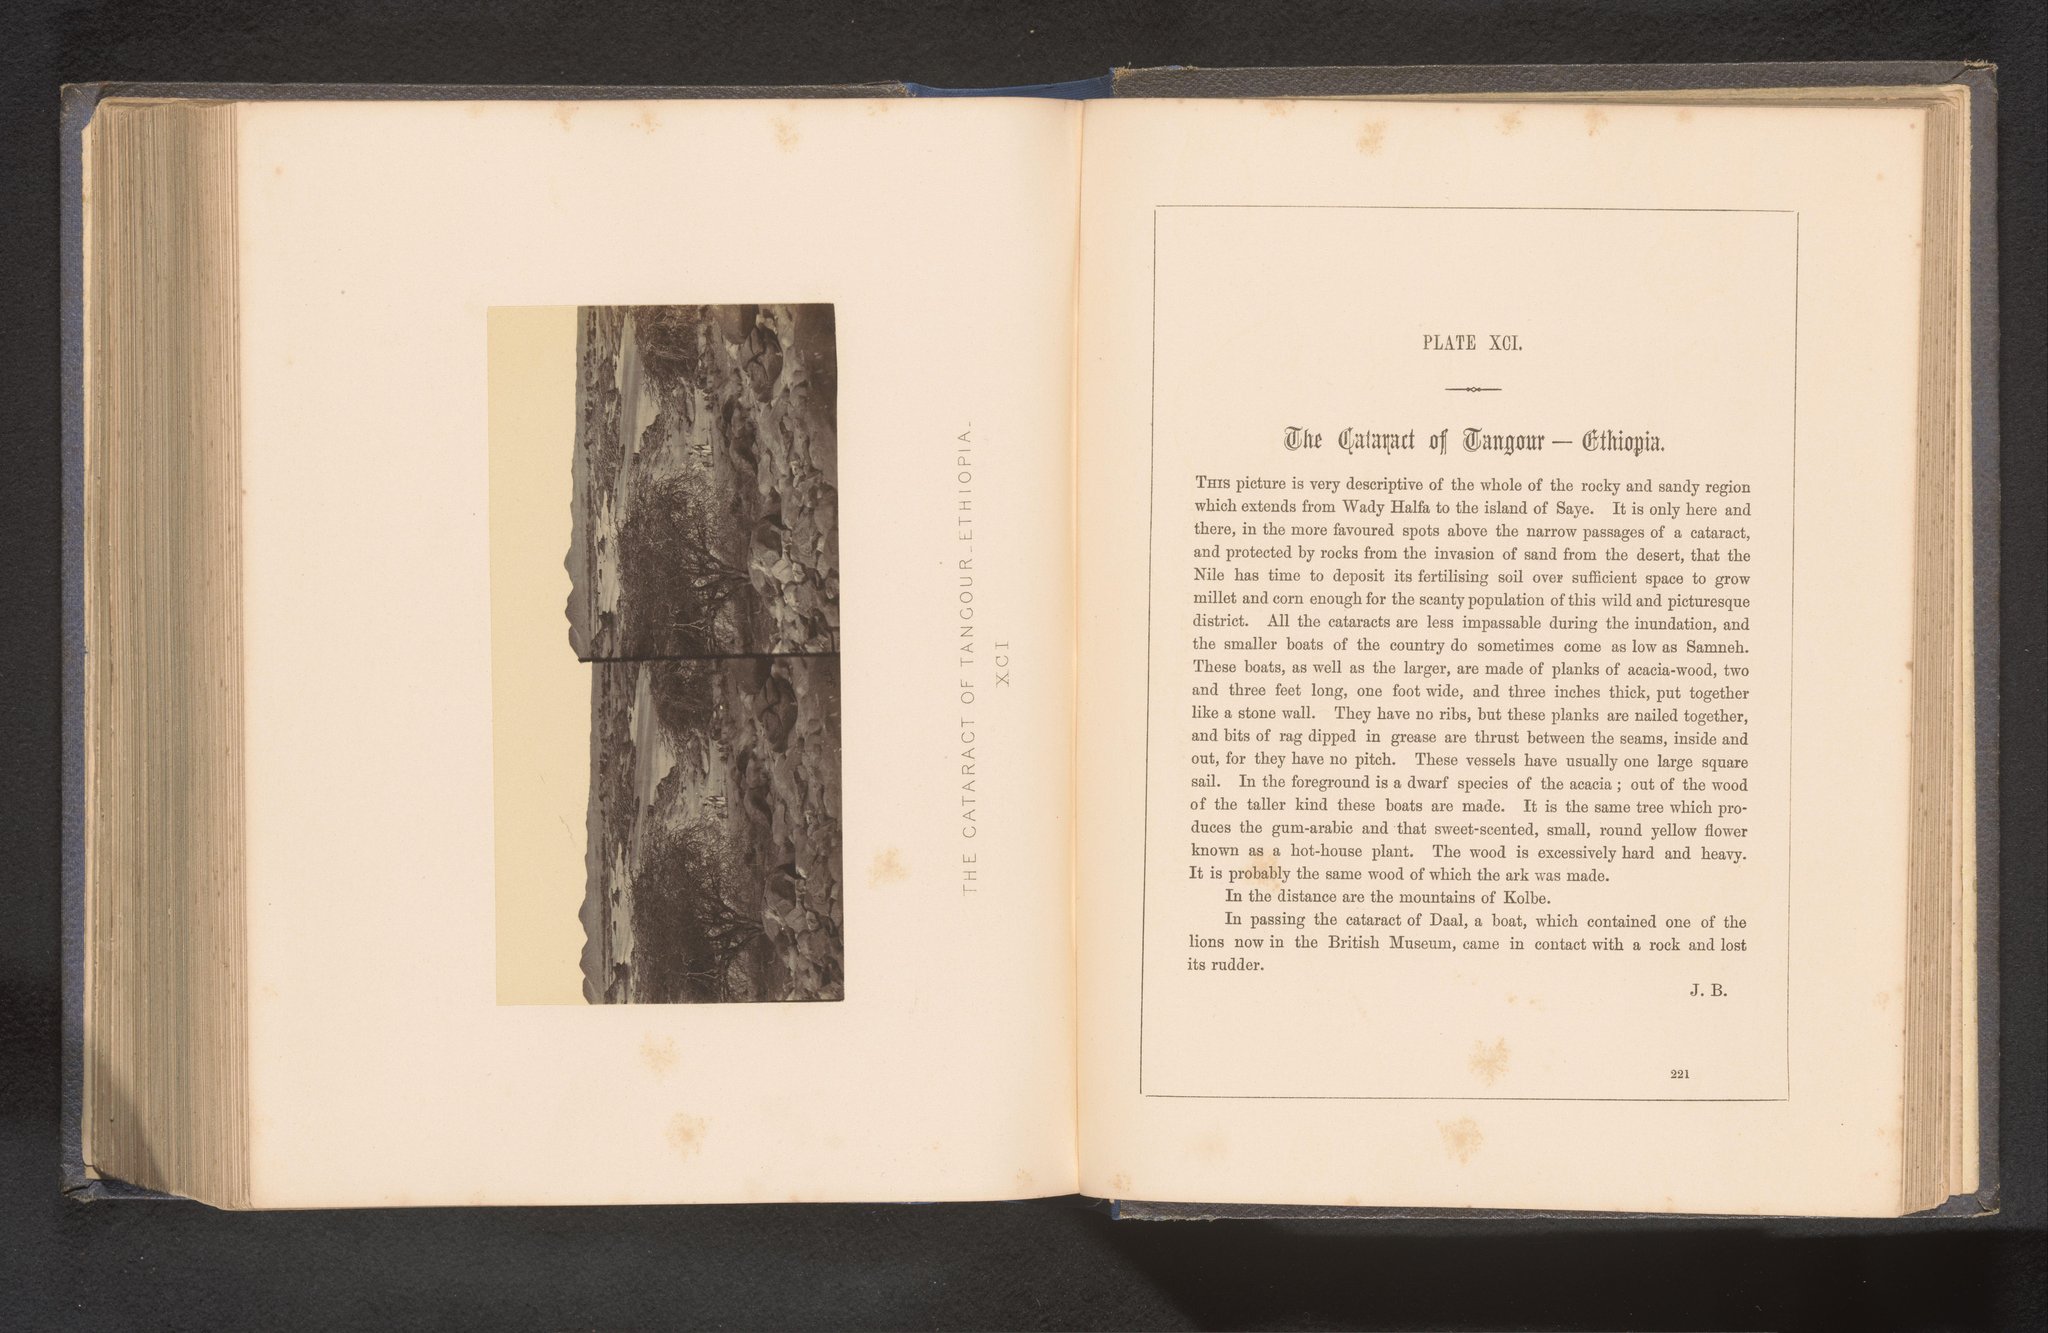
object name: stereograph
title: Gezicht op het Cataract van Tangour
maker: francis frith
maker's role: publisher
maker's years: 1822-1898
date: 1857-1862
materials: photographic support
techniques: albumen print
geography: north africa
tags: landscapes with waters, waterscapes, seascapes (in the temperate zone)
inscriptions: number: ‘XCI’, name: ‘Frith’